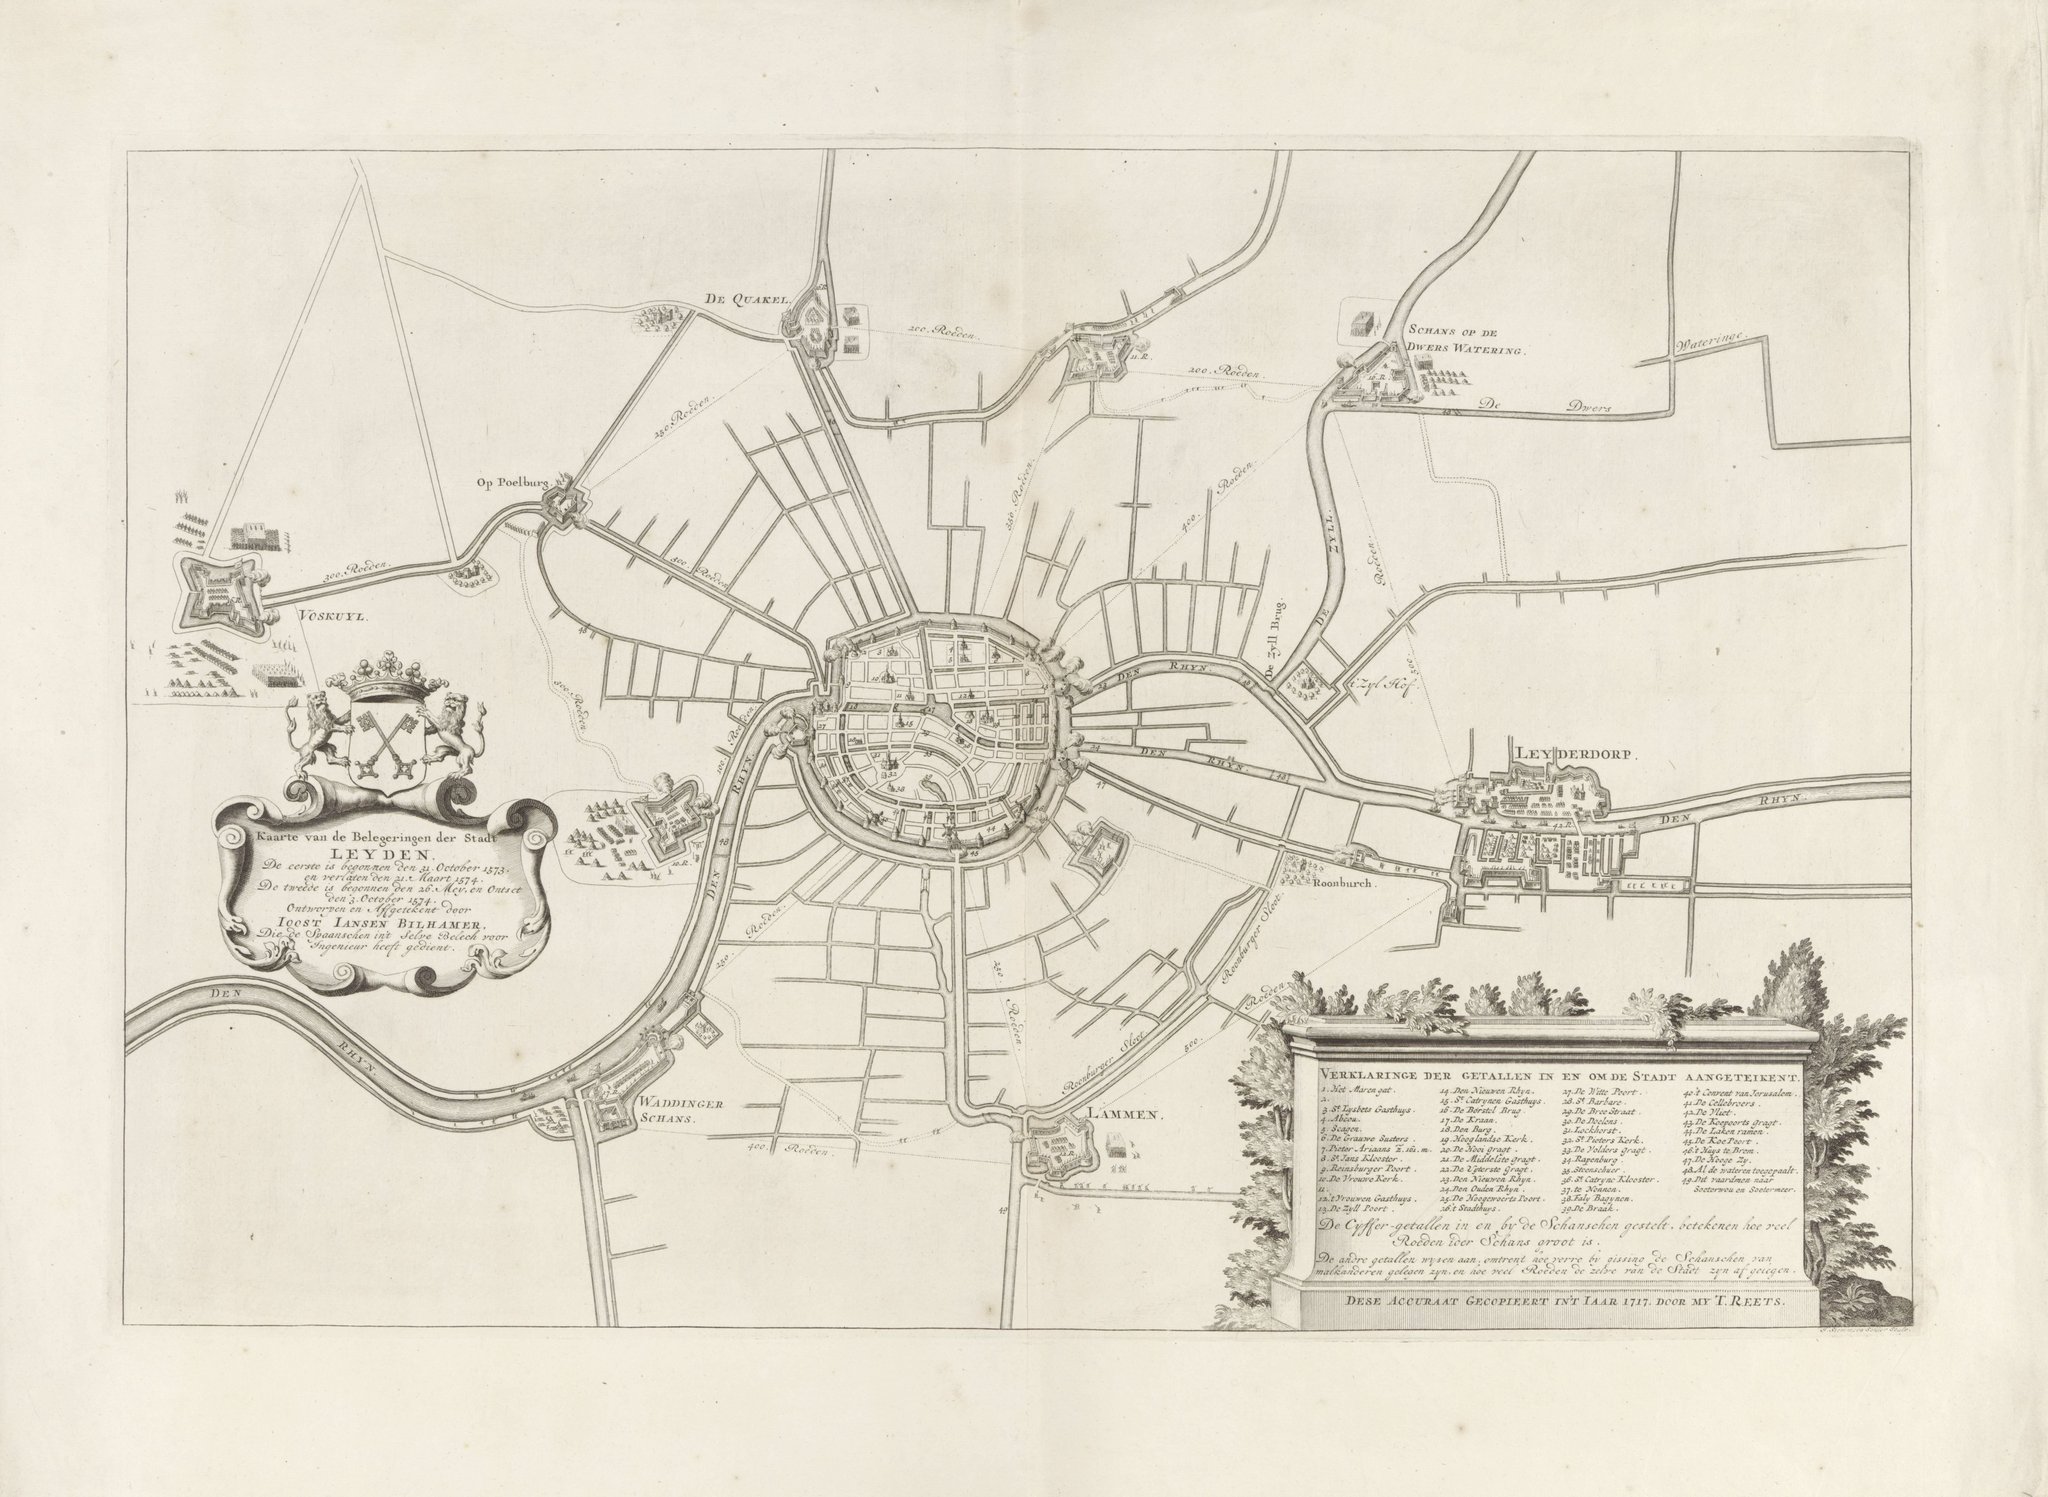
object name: print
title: Kaart van het beleg van Leiden, 1573-1574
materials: paper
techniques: engraving, etching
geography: northern netherlands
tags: coat of arms (as symbol of the state, etc.) (+ city; municipal), siege, position war, maps of cities, leiden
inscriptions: collector's mark: Lugt 240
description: Belegeringen van de stad Leiden in de jaren 1573-1574 door de Spanjaarden. Kaart met plattegrond van de stad en de omgeving tot Leiderdorp en De Kwakel, met alle schansen in de omgeving. Links een cartouche met de titel en het stadswapen, rechts een cartouche op een voetstuk met de legenda 1-49 in het Nederlands.